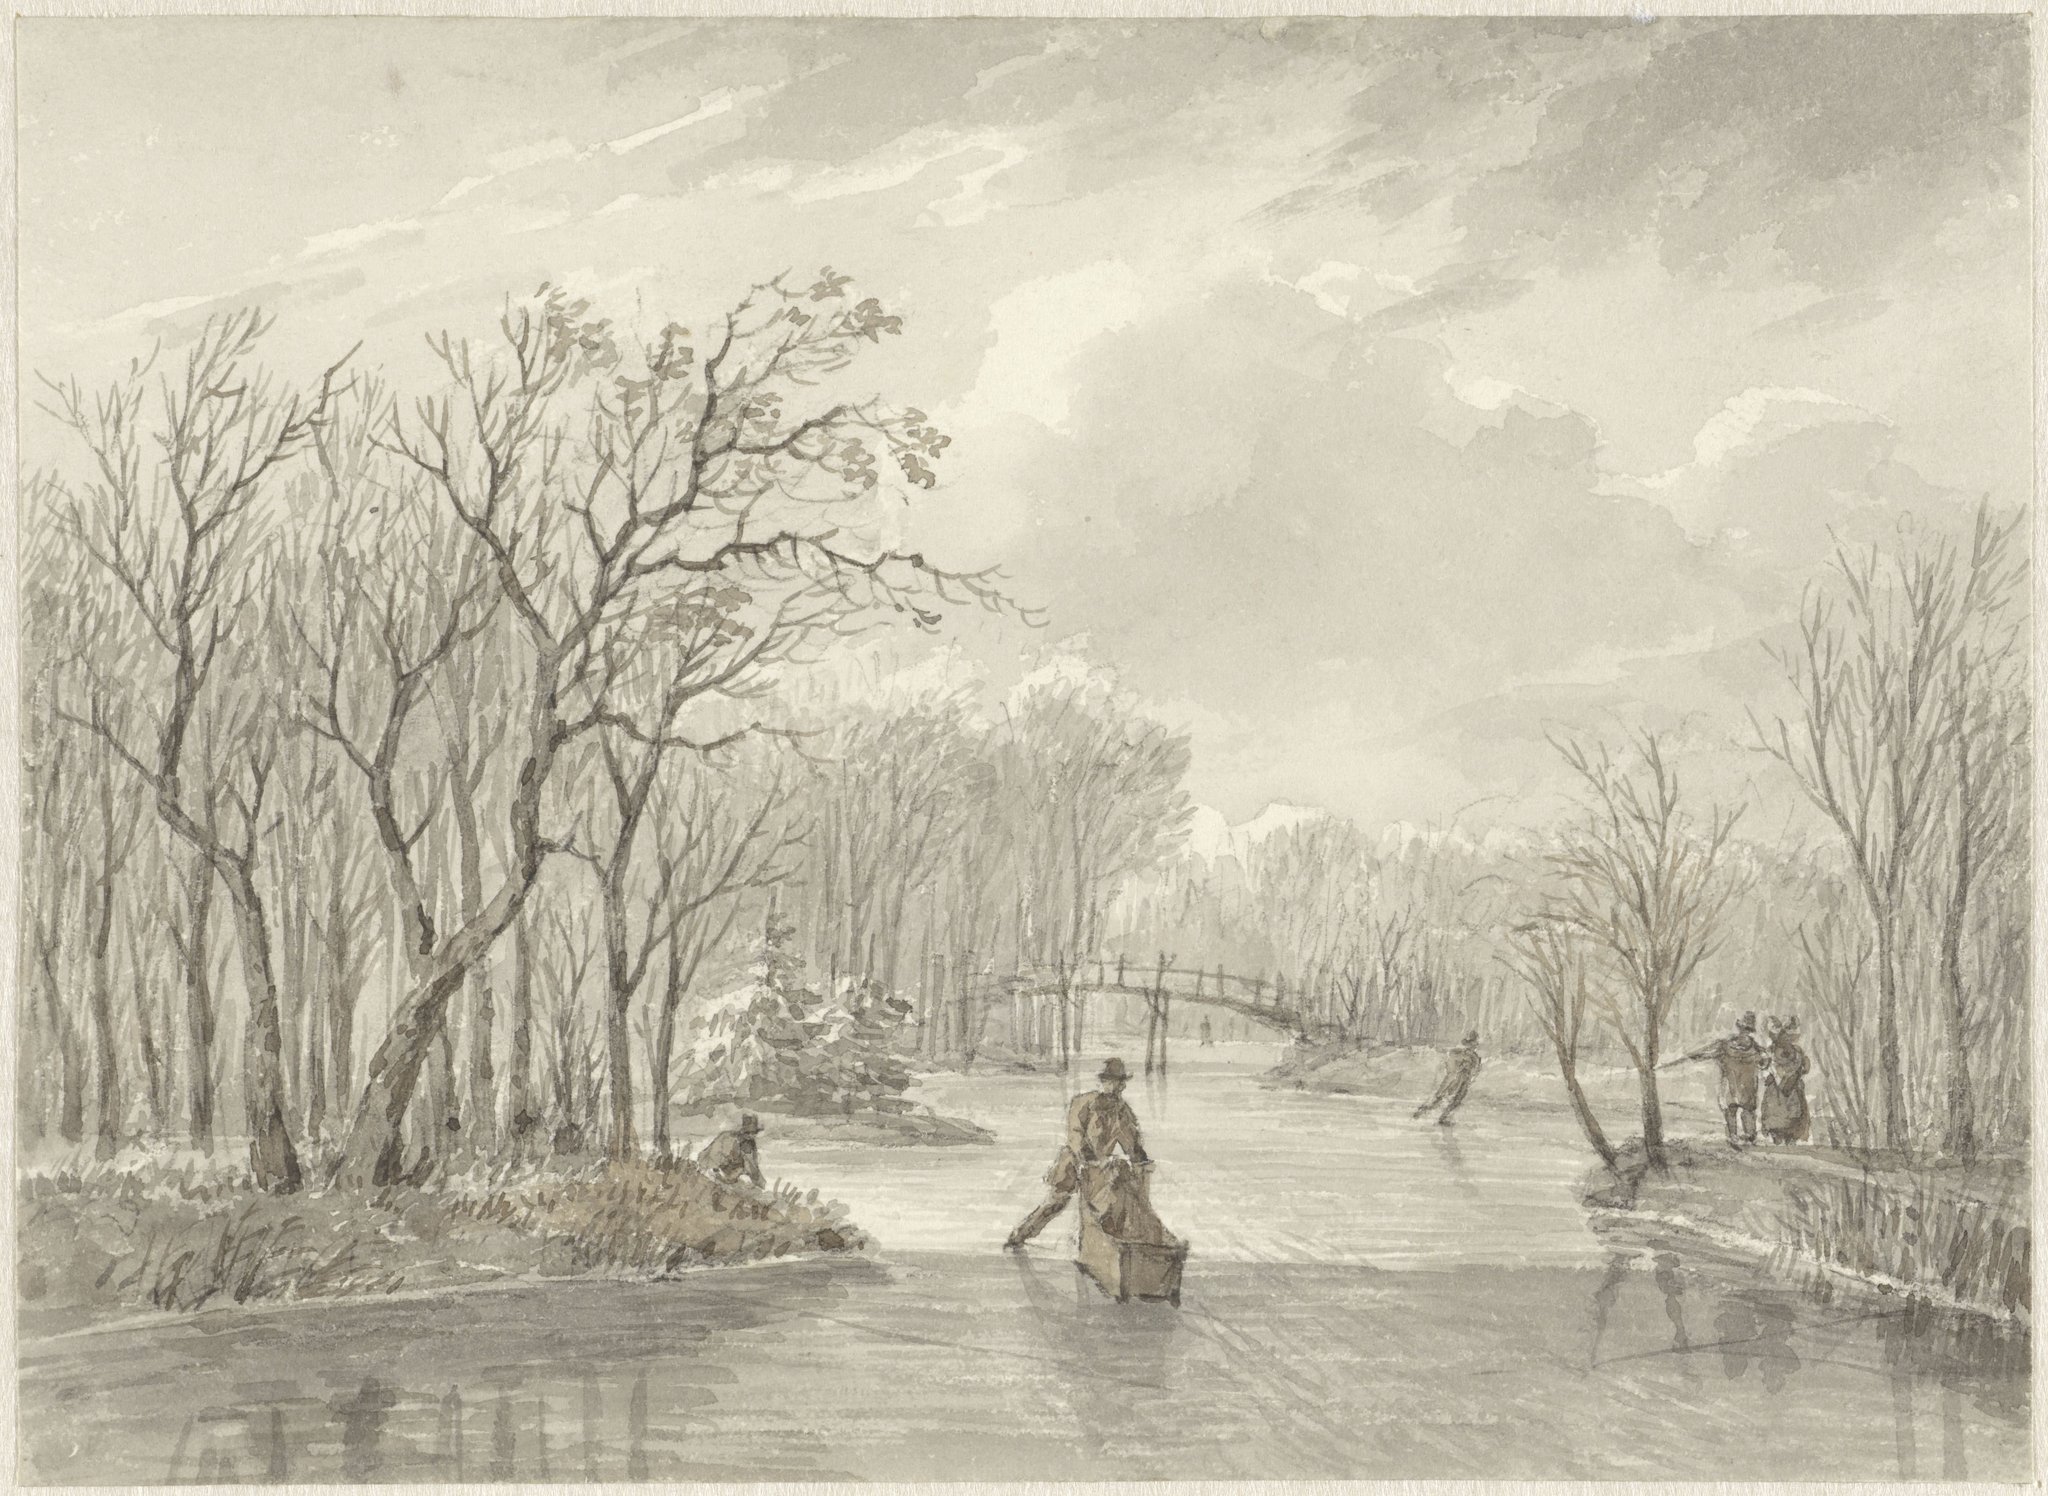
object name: drawing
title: Wintergezicht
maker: daniël van oosterhoudt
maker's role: draughtsman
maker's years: 1781-1850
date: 1791-1850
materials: chalk, paper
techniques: brush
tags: playing with snow and ice - cc - adult(s) ~ snow and ice, ice ~ freezing weather